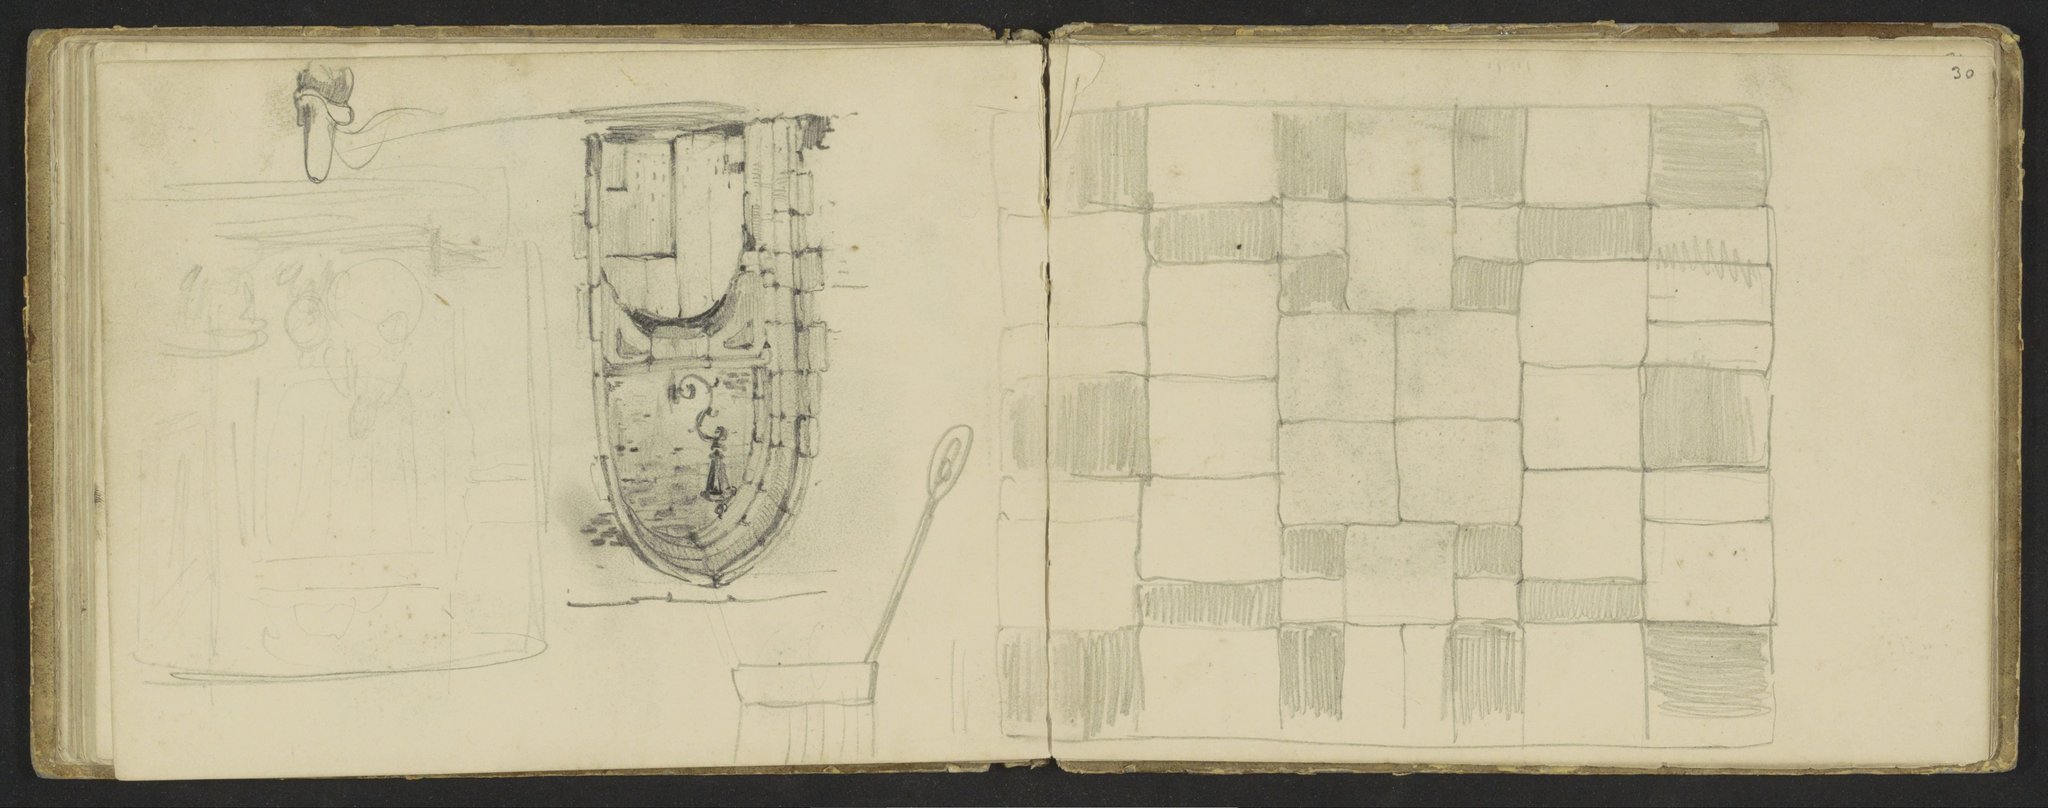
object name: sketchbook leaf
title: Tegelvoer, een portaal en een interieur met figuur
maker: willem hendrik schmidt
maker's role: draughtsman, painter, print maker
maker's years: 1809-1849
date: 1819-1849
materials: paper, pencil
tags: gate, entrance, interior of the house, pavement, floor ~ architecture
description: Blad 29 verso en 30 recto uit een schetsboek met 36 bladen.